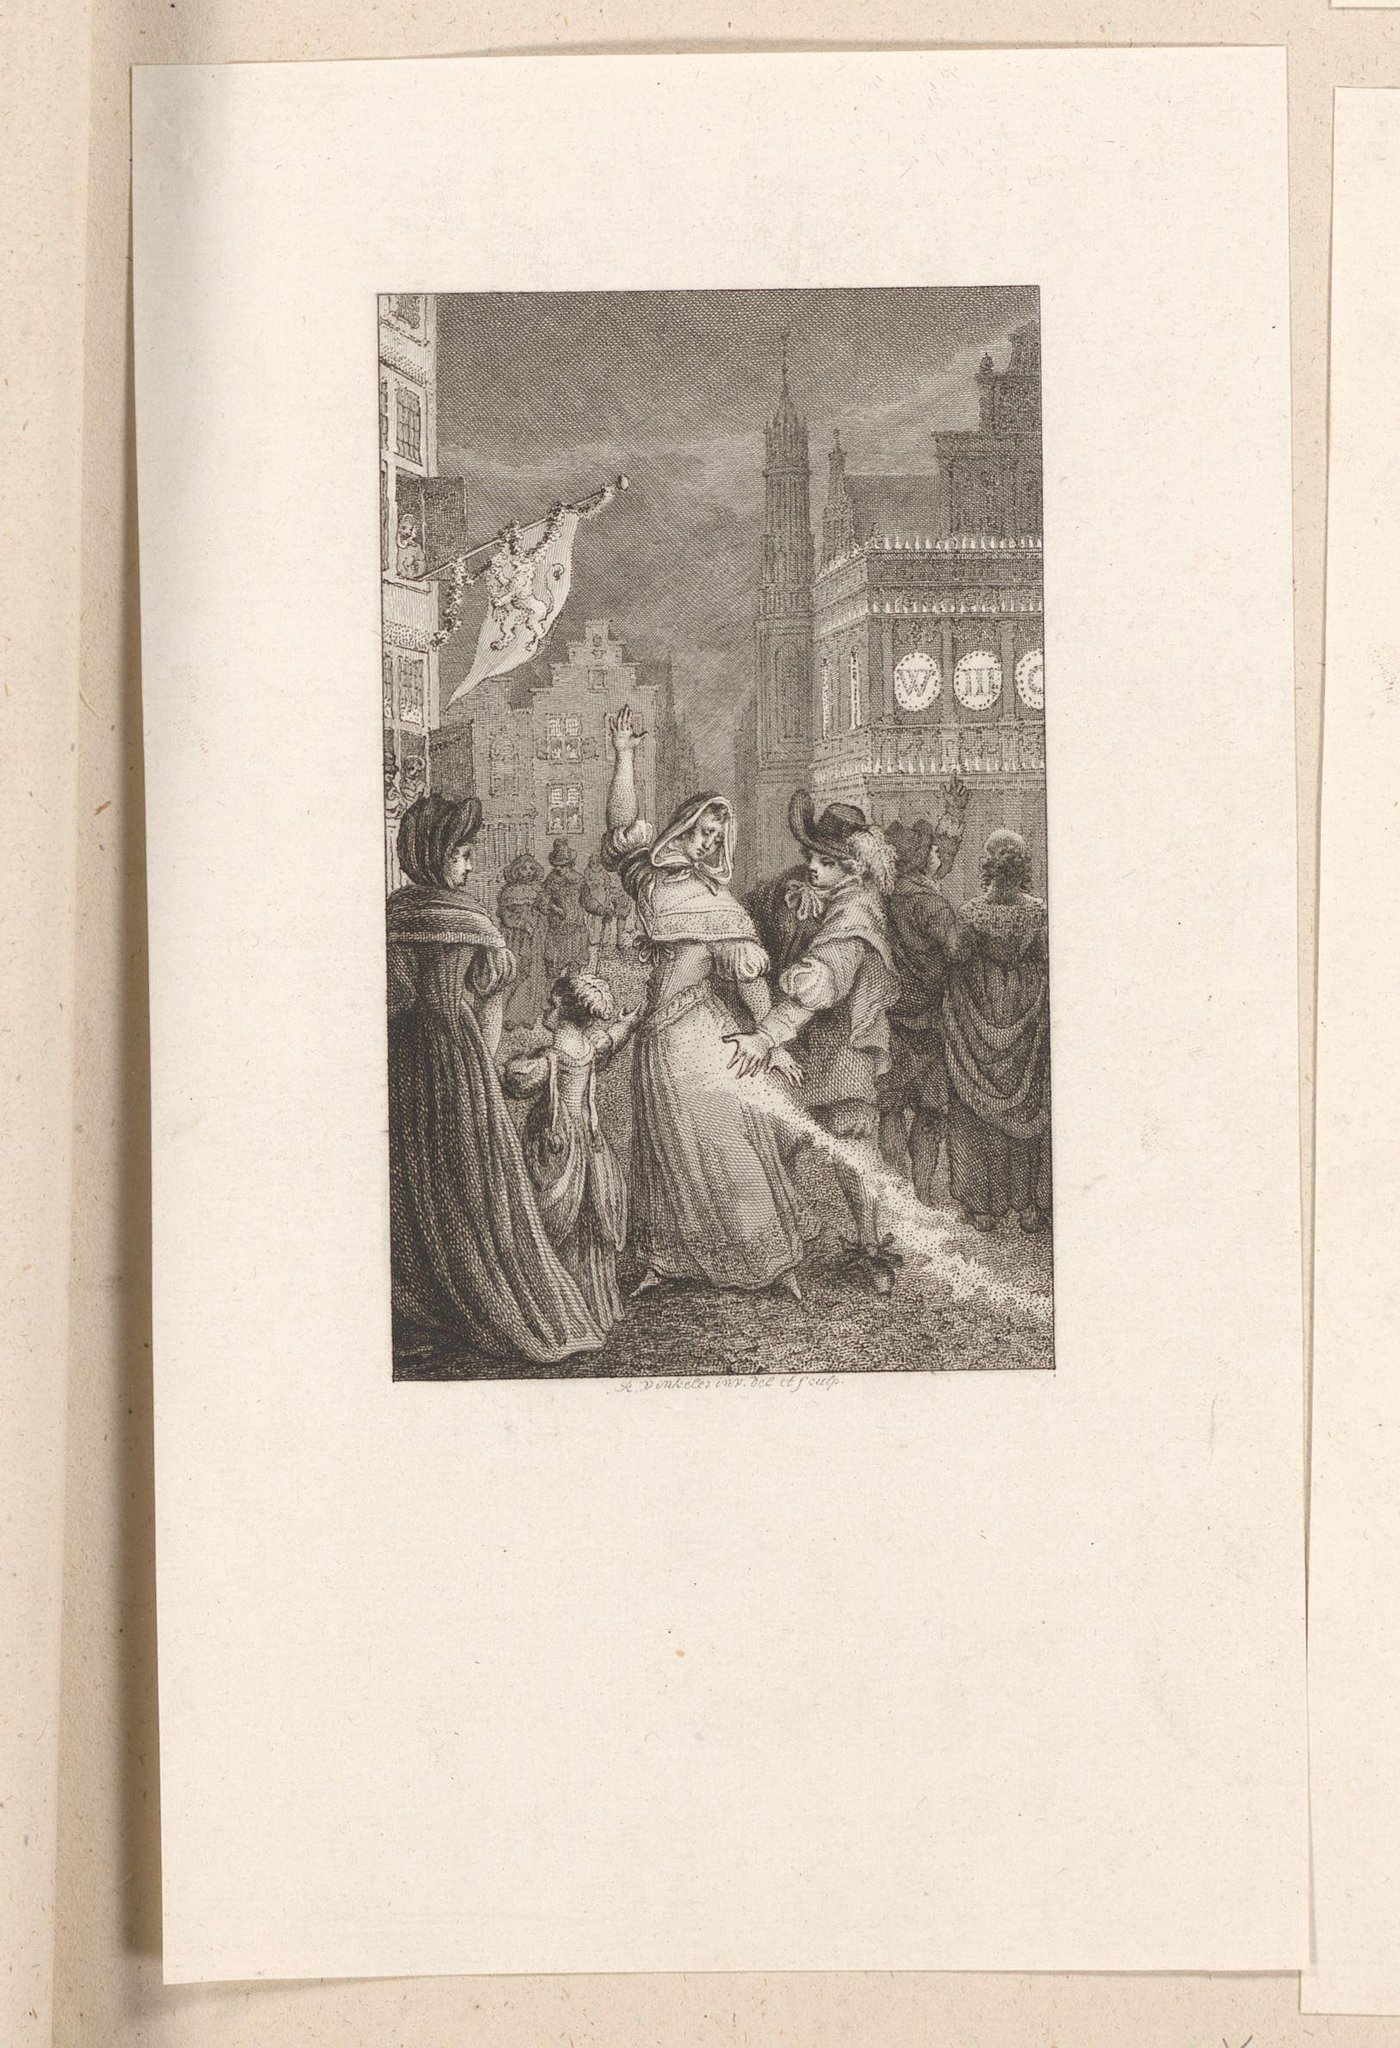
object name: print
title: Hellemans redt een dame van rondvliegend vuur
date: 1815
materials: paper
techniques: engraving, etching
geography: haarlem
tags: public festivities, rescue from fire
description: Een straat in een stad bij avond. Hellemans redt een dame van rondvliegend vuur. Rechts kijkt een paar naar de lucht. Links een vrouw met kind. Er hangt een vlag met een klimmende leeuw uit het raam. De prent maakt deel uit van een album.